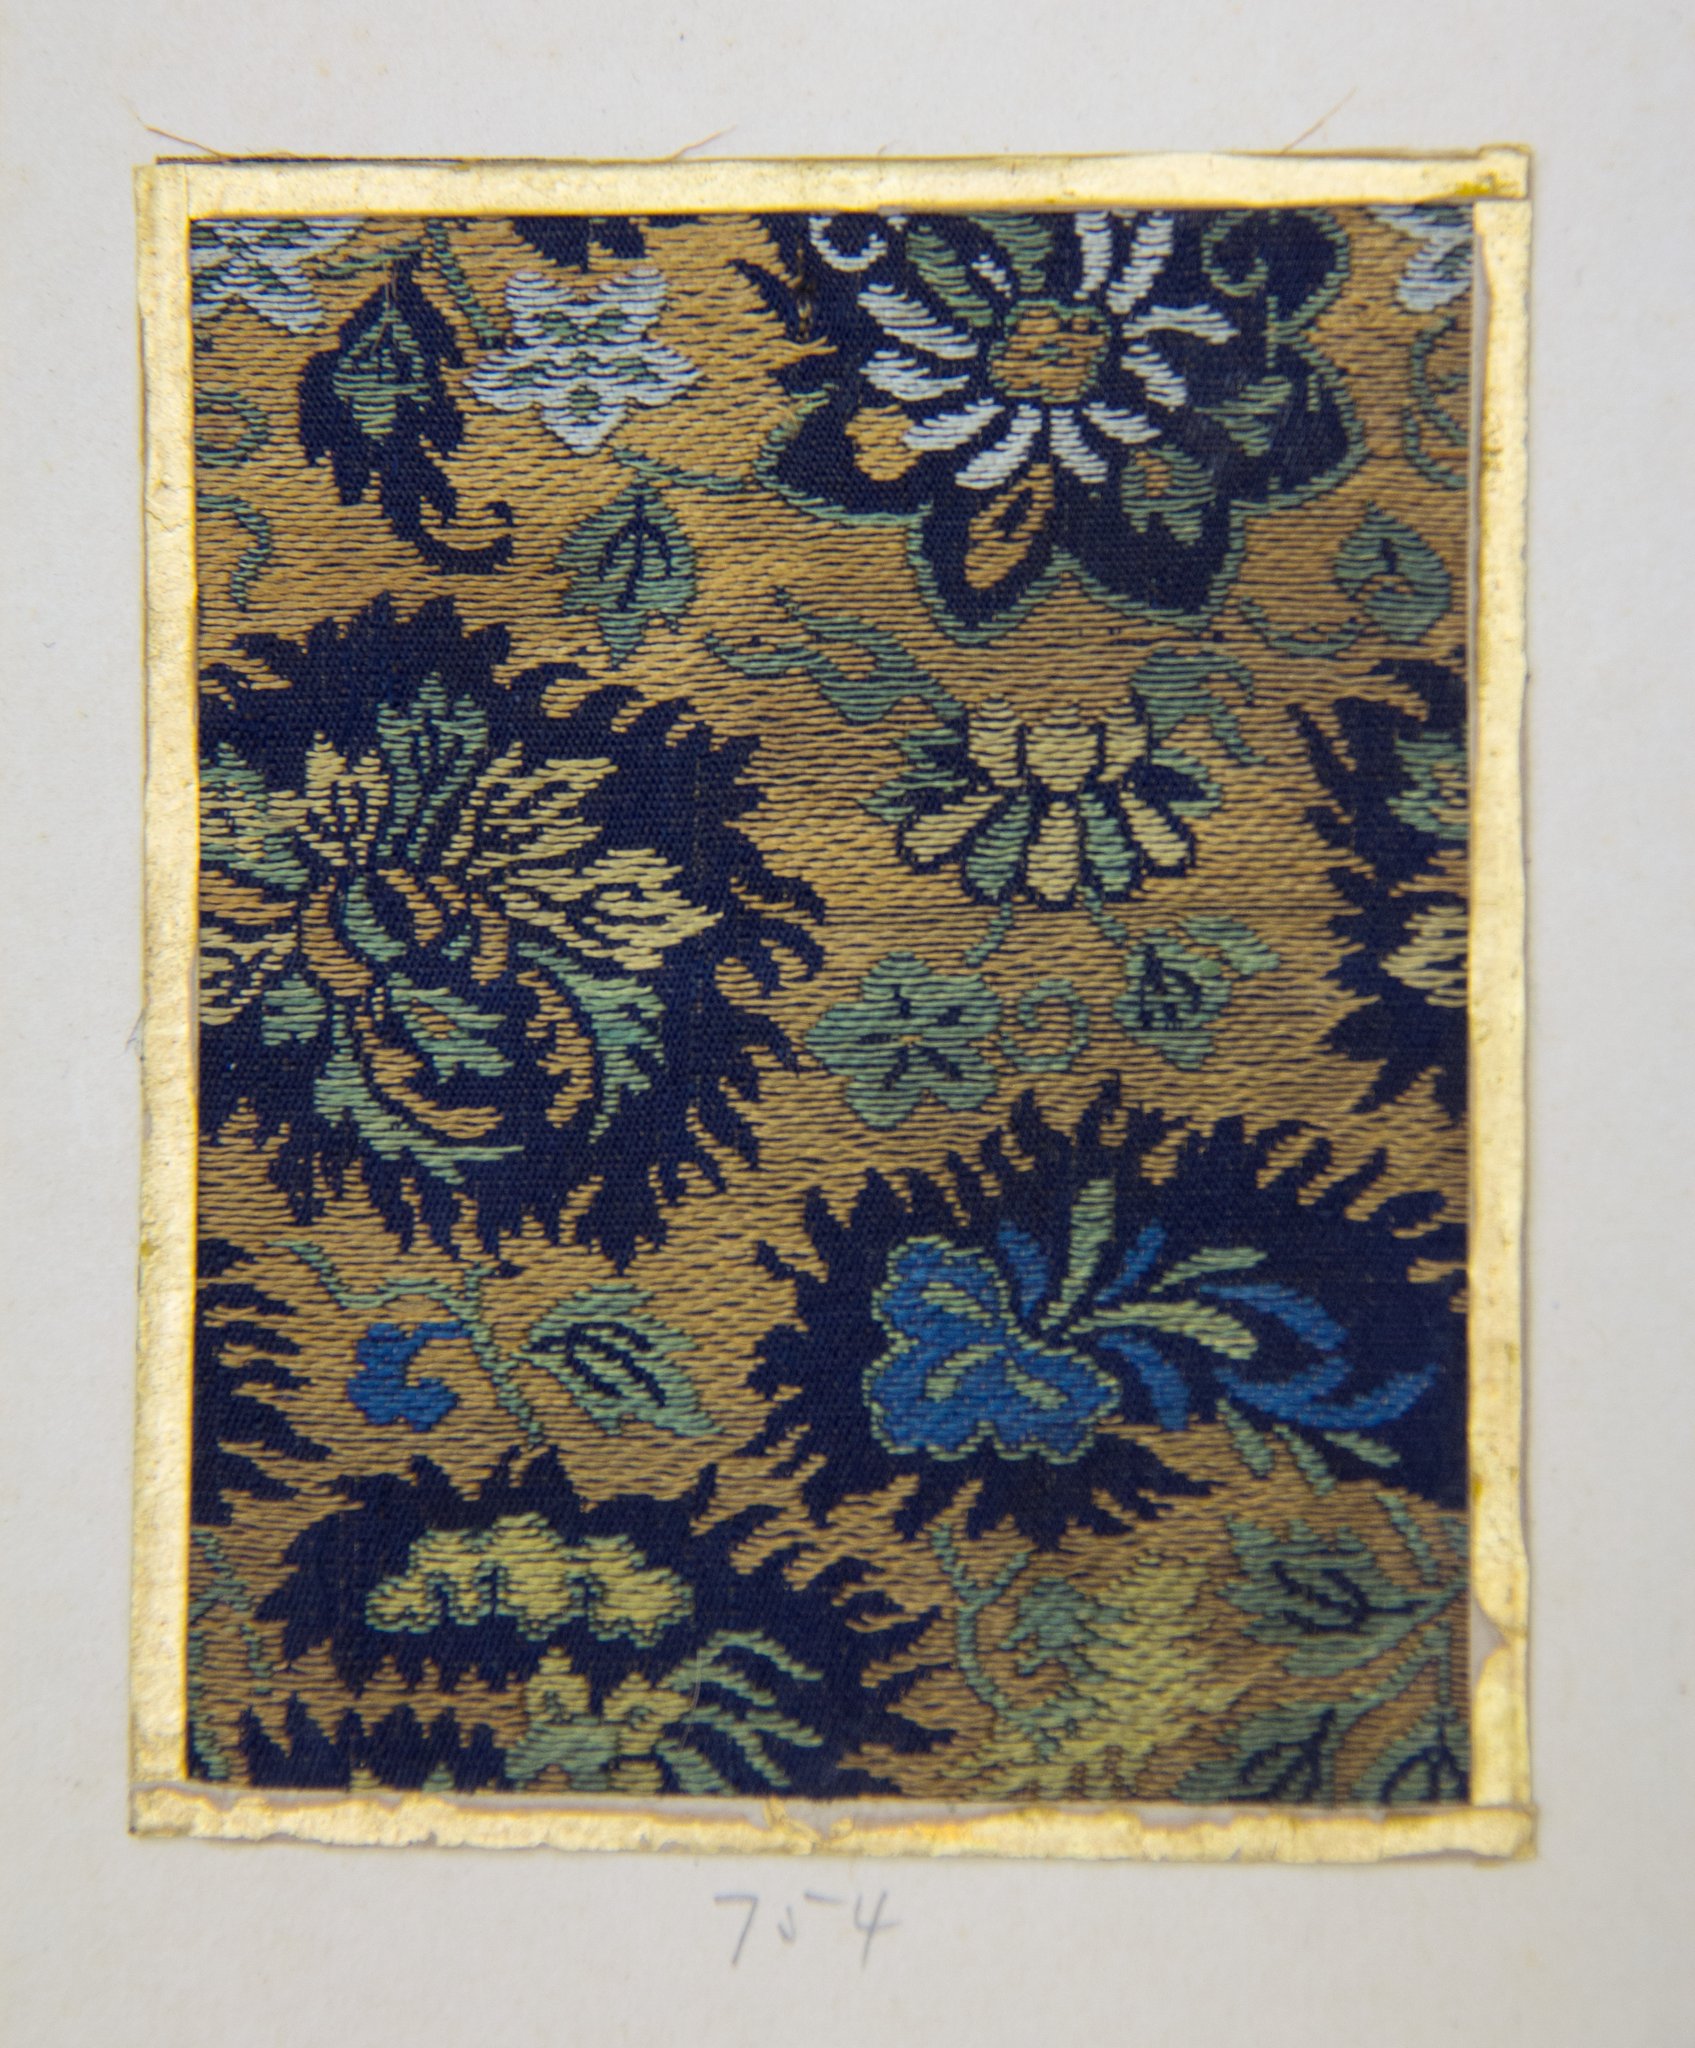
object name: piece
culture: japanese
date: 1801-1900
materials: silk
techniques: compound weave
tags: flowers